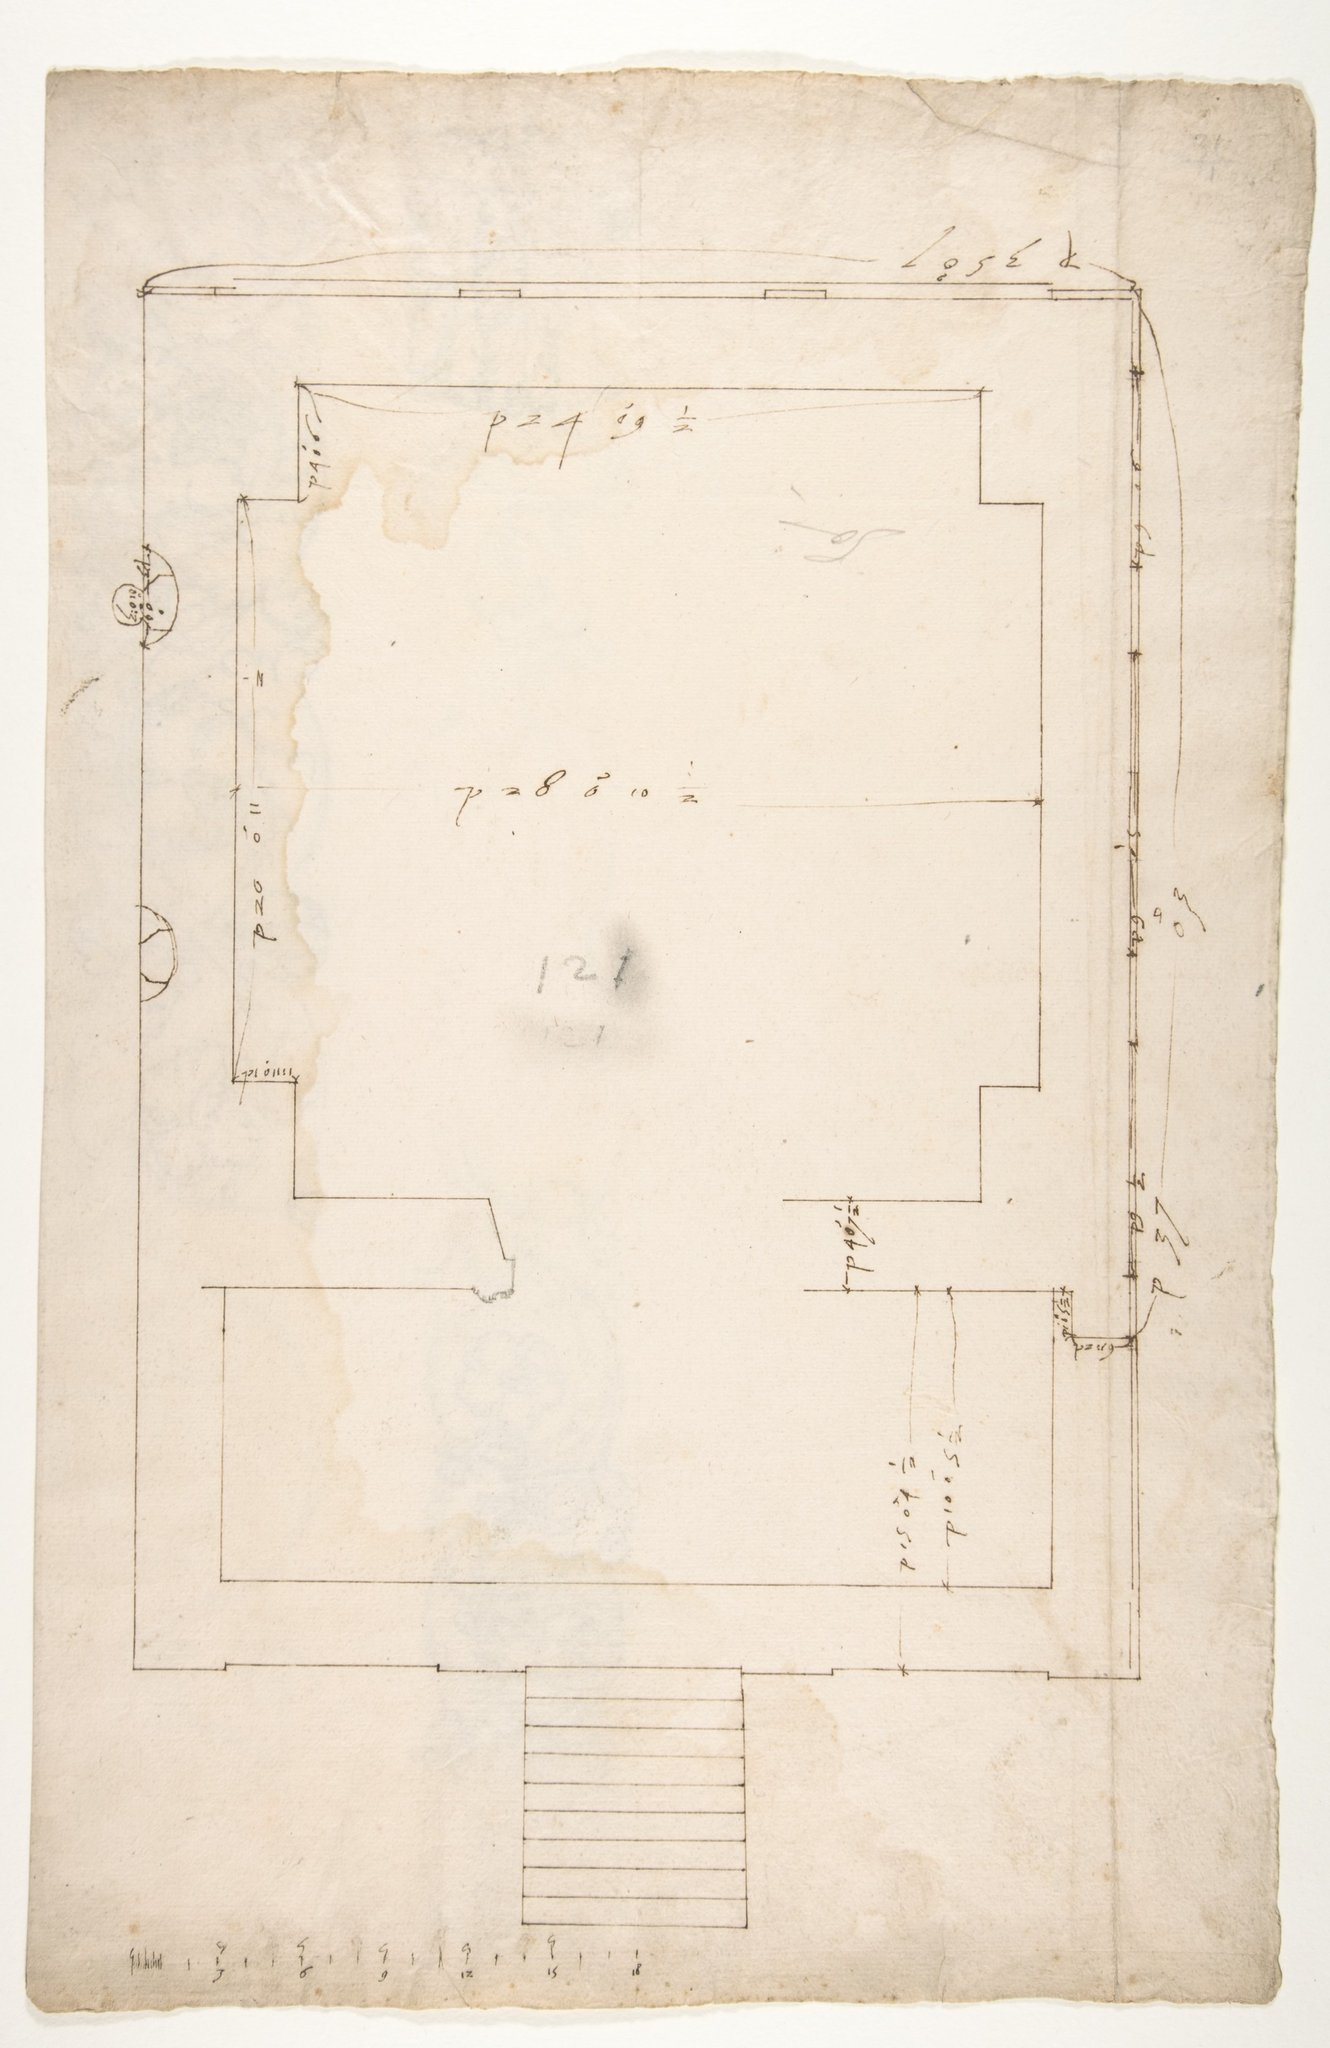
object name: collection ornament architecture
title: Tomb of Annia Regilla, plan (recto) Arch of the Argentarii, ornamental details, elevation (verso)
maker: anonymous, french, 16th century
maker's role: draftsman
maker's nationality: french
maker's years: 1500-1600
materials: chalk, ink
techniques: incising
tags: architecture,tombs